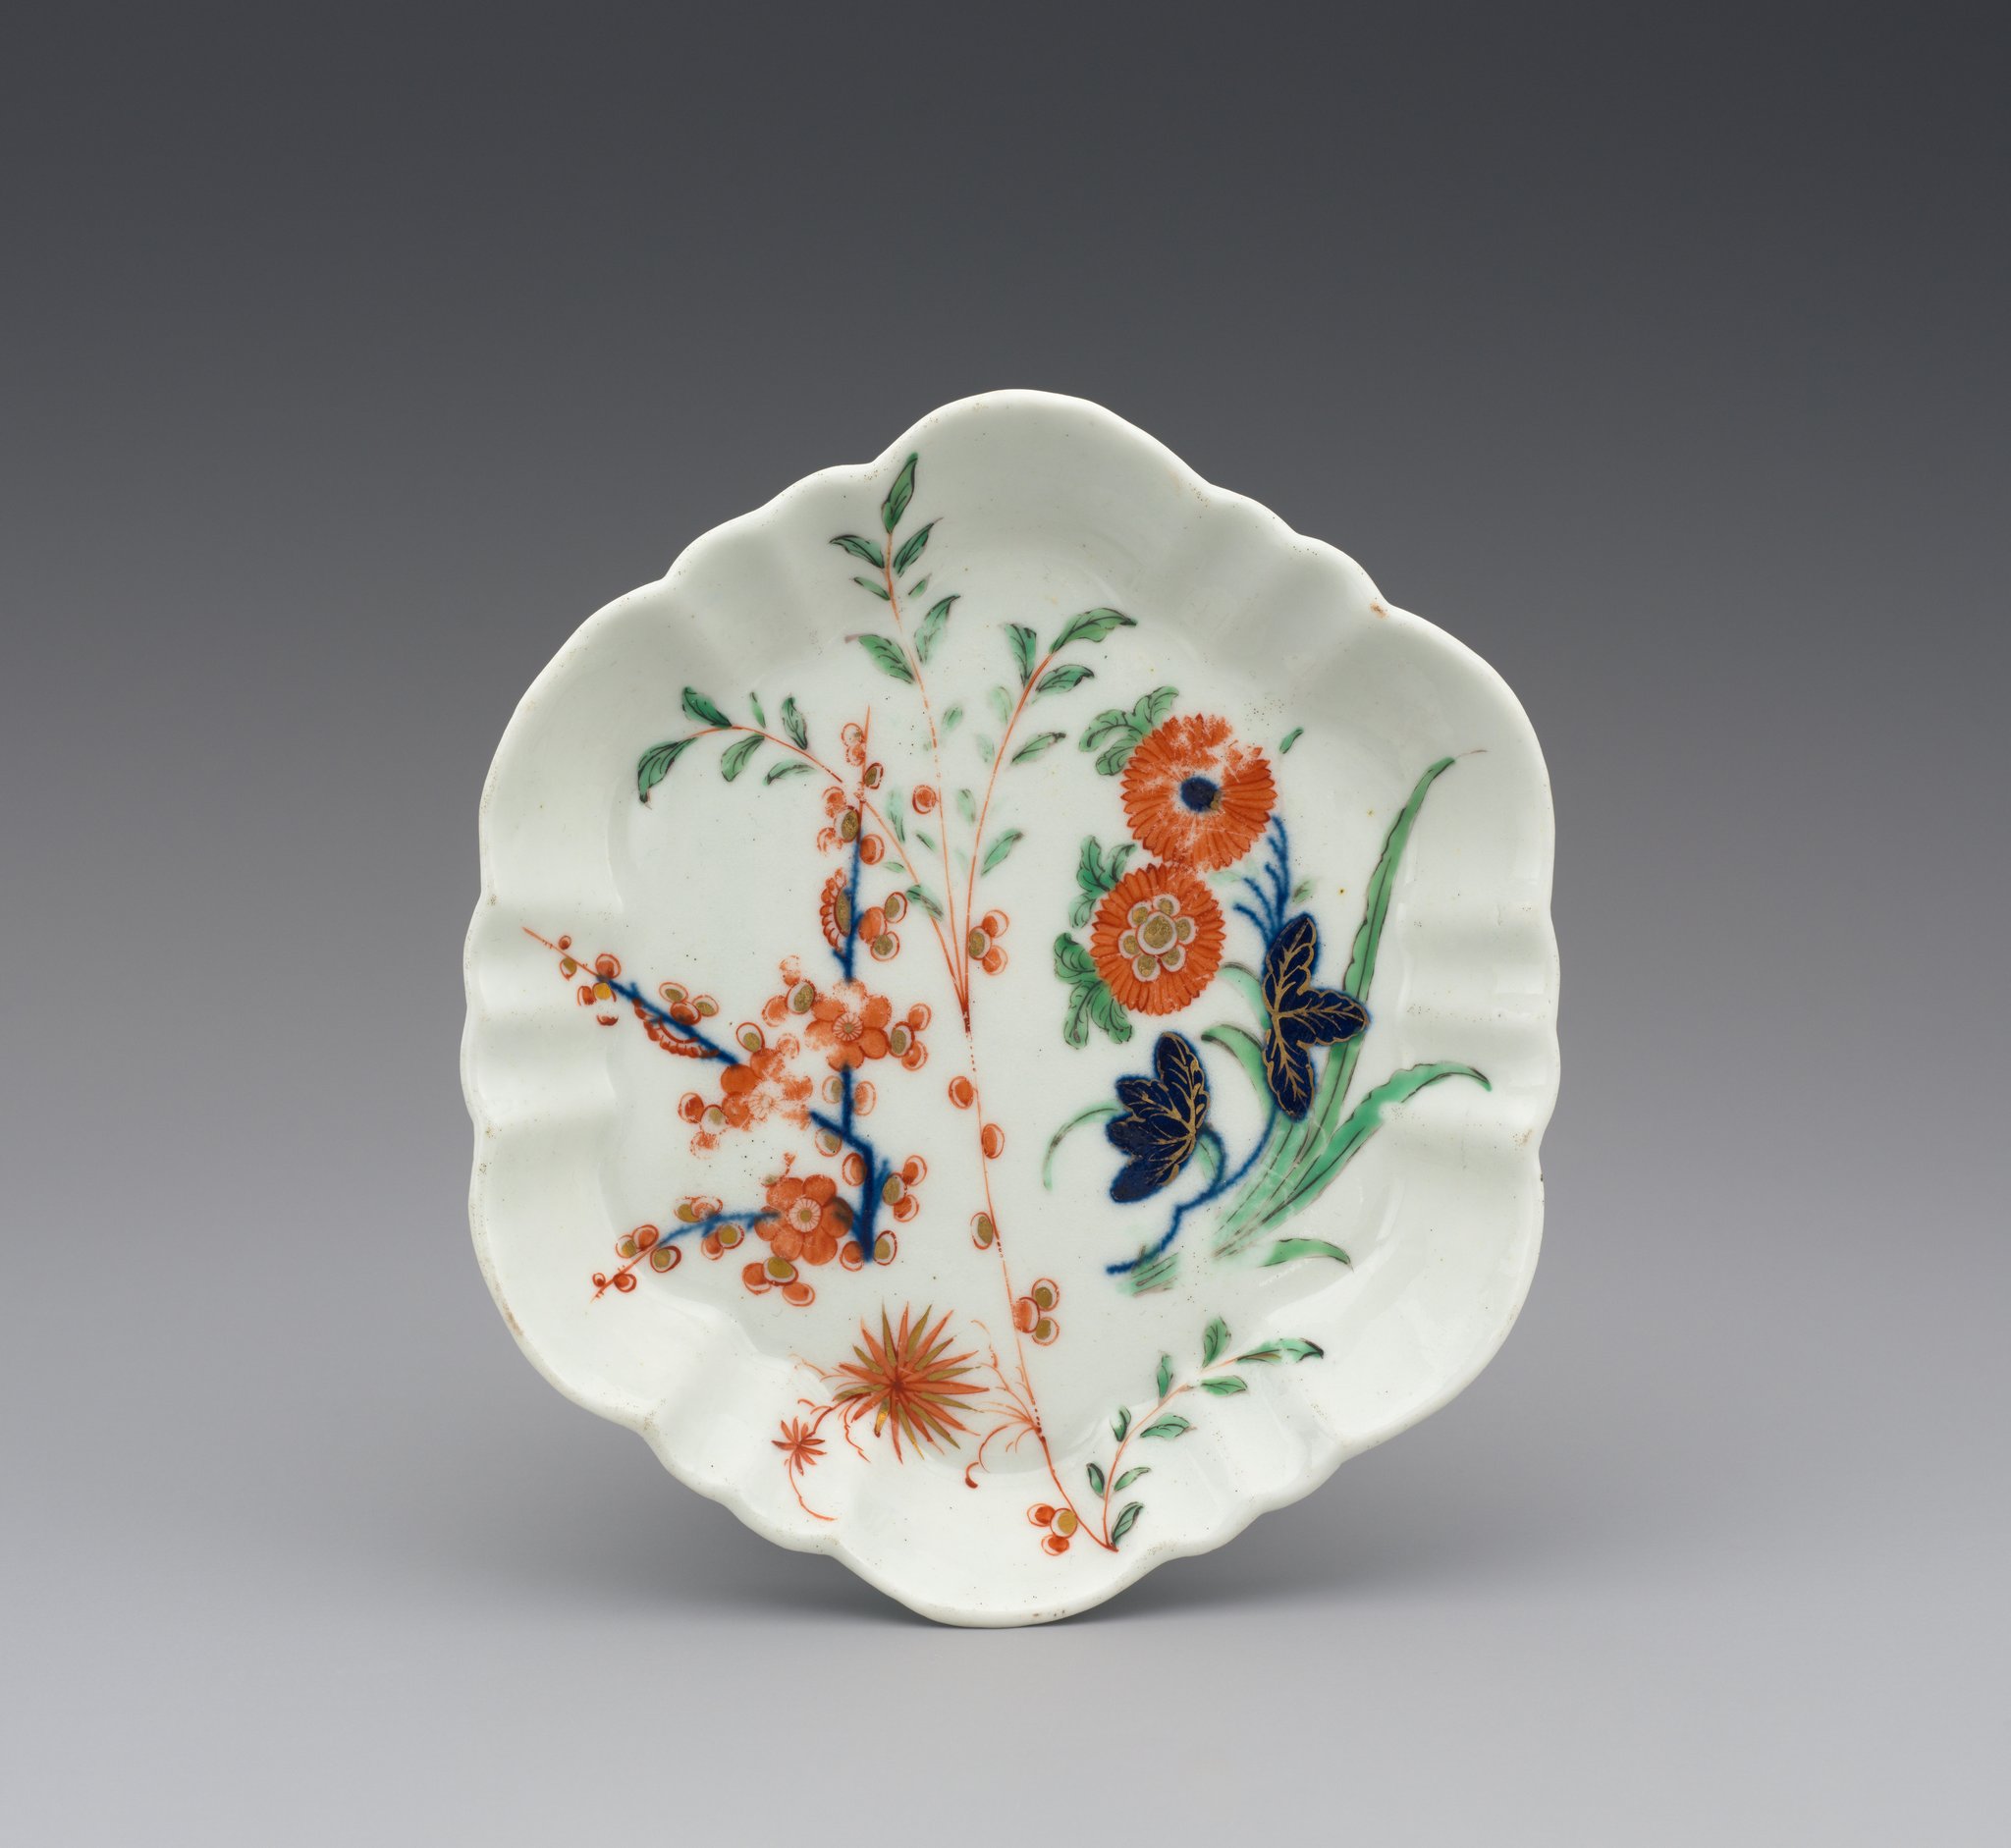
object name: stand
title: Stand (part of a service)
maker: worcester factory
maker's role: factory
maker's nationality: british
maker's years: 1751-2008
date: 1765-1770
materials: soft paste porcelain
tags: flowers